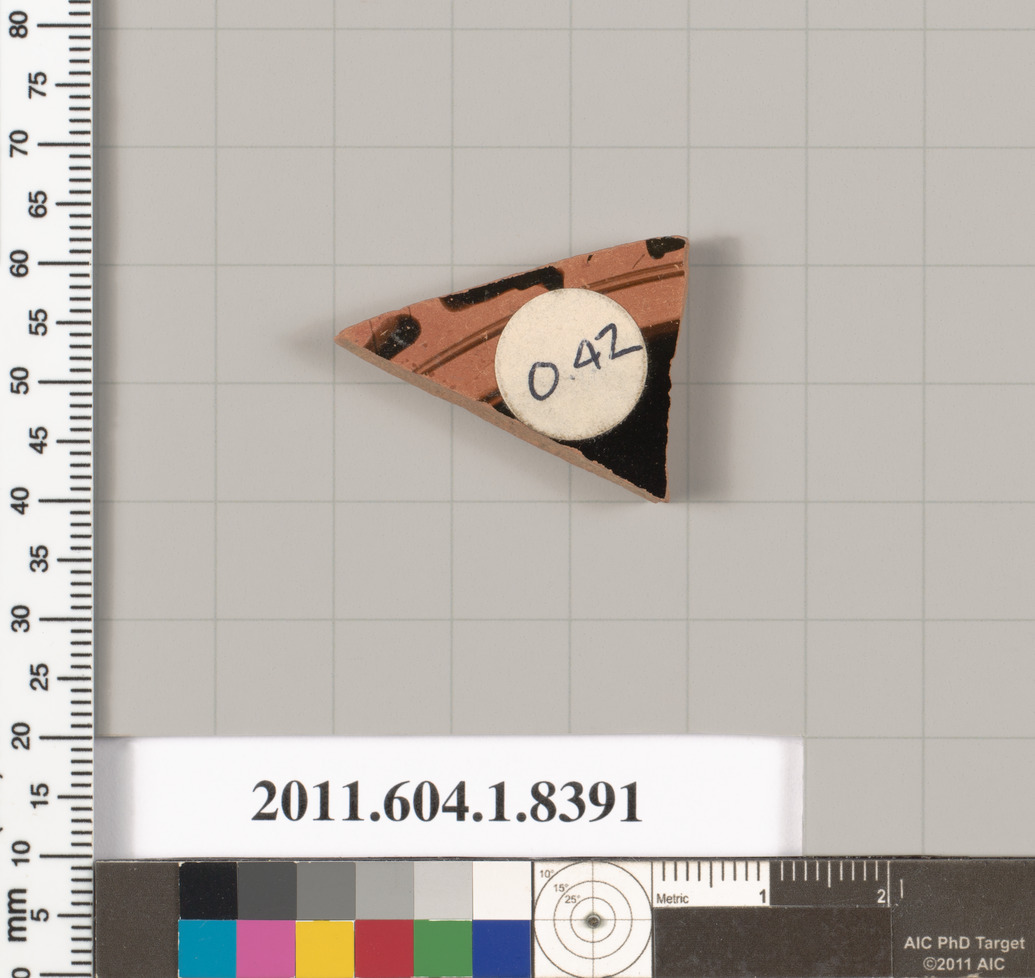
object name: kylix fragment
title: Terracotta fragment of a kylix (drinking cup)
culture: greek, attic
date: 367-335 BCE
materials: terracotta